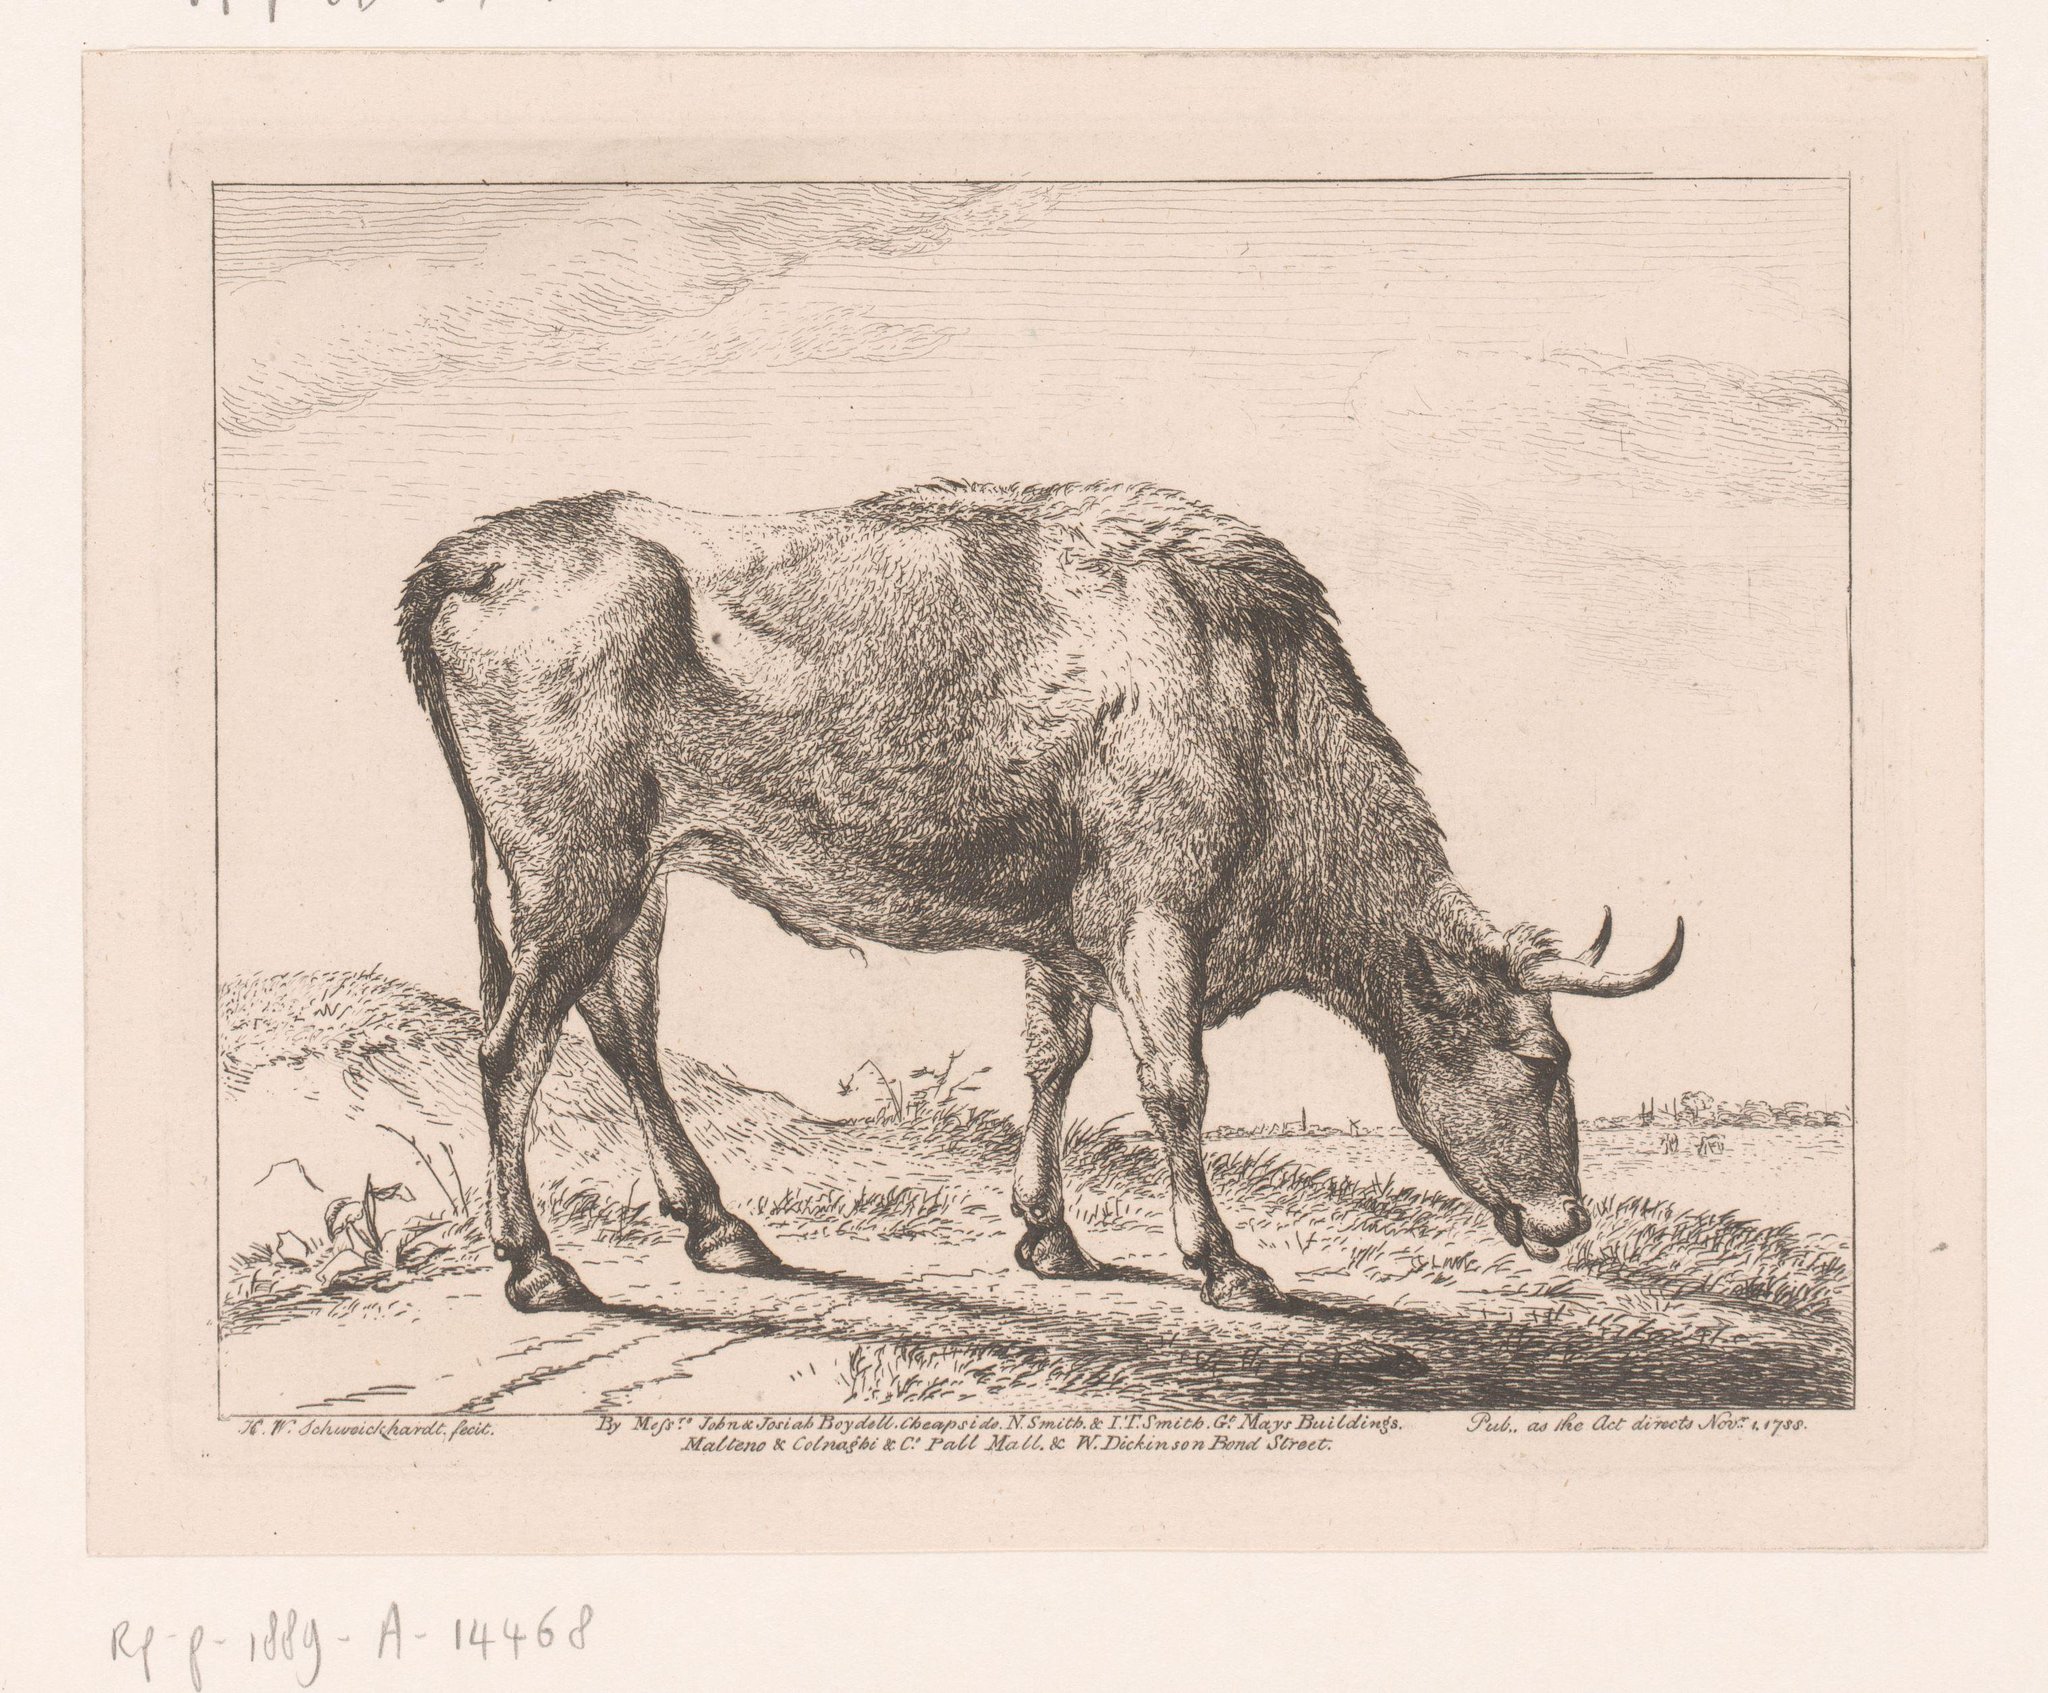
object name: print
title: Verschillende dieren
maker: hendrik willem schweickhardt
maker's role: draughtsman, painter, print maker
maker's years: 1746-1797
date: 1788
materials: paper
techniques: etching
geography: london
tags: bull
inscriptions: collector's mark: Lugt 2228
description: Behoort tot een serie van acht prenten met verschillende dieren.